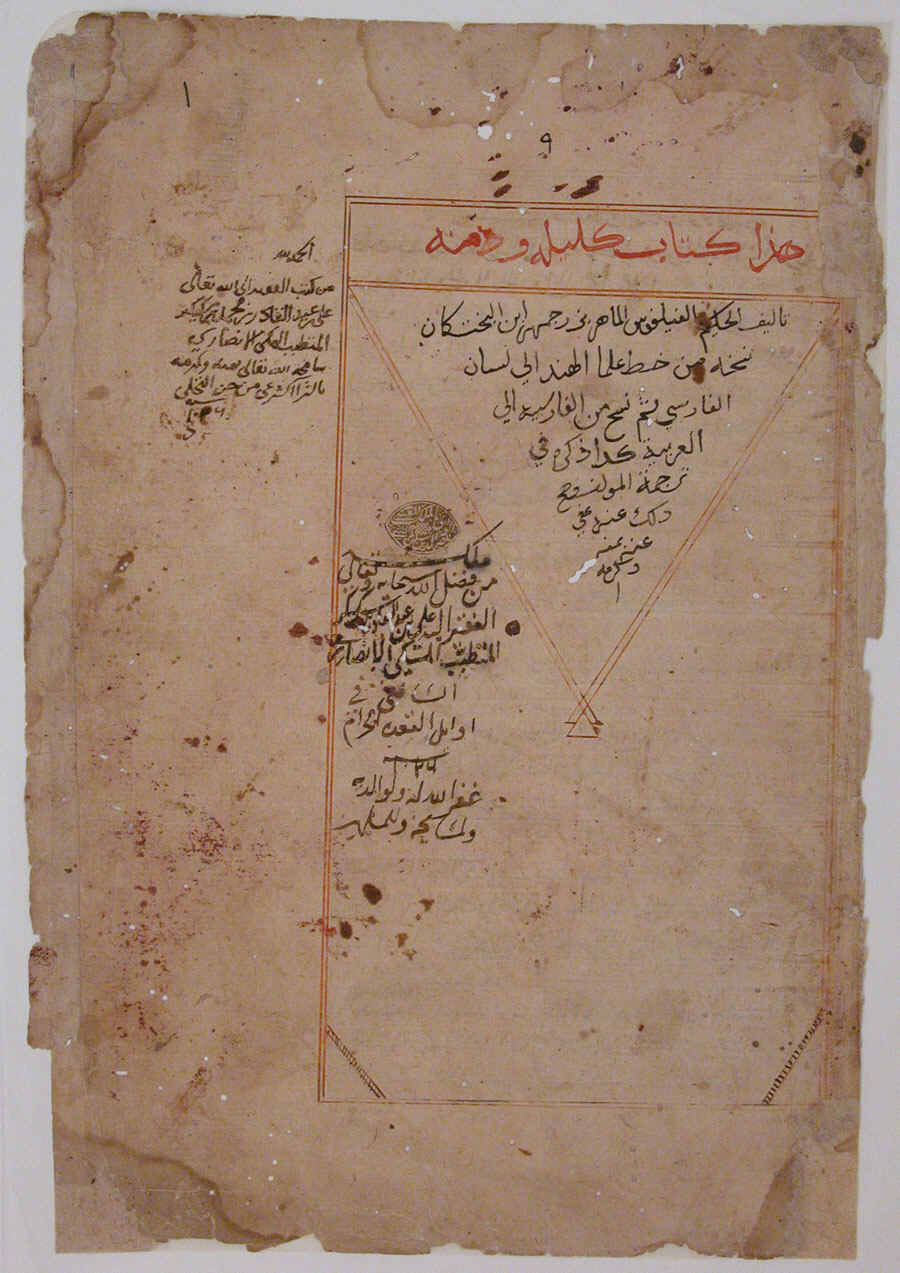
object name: folio from an illustrated manuscript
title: Opening Page from a Kalila wa Dimna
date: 1526-1550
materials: ink, paper, watercolor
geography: india